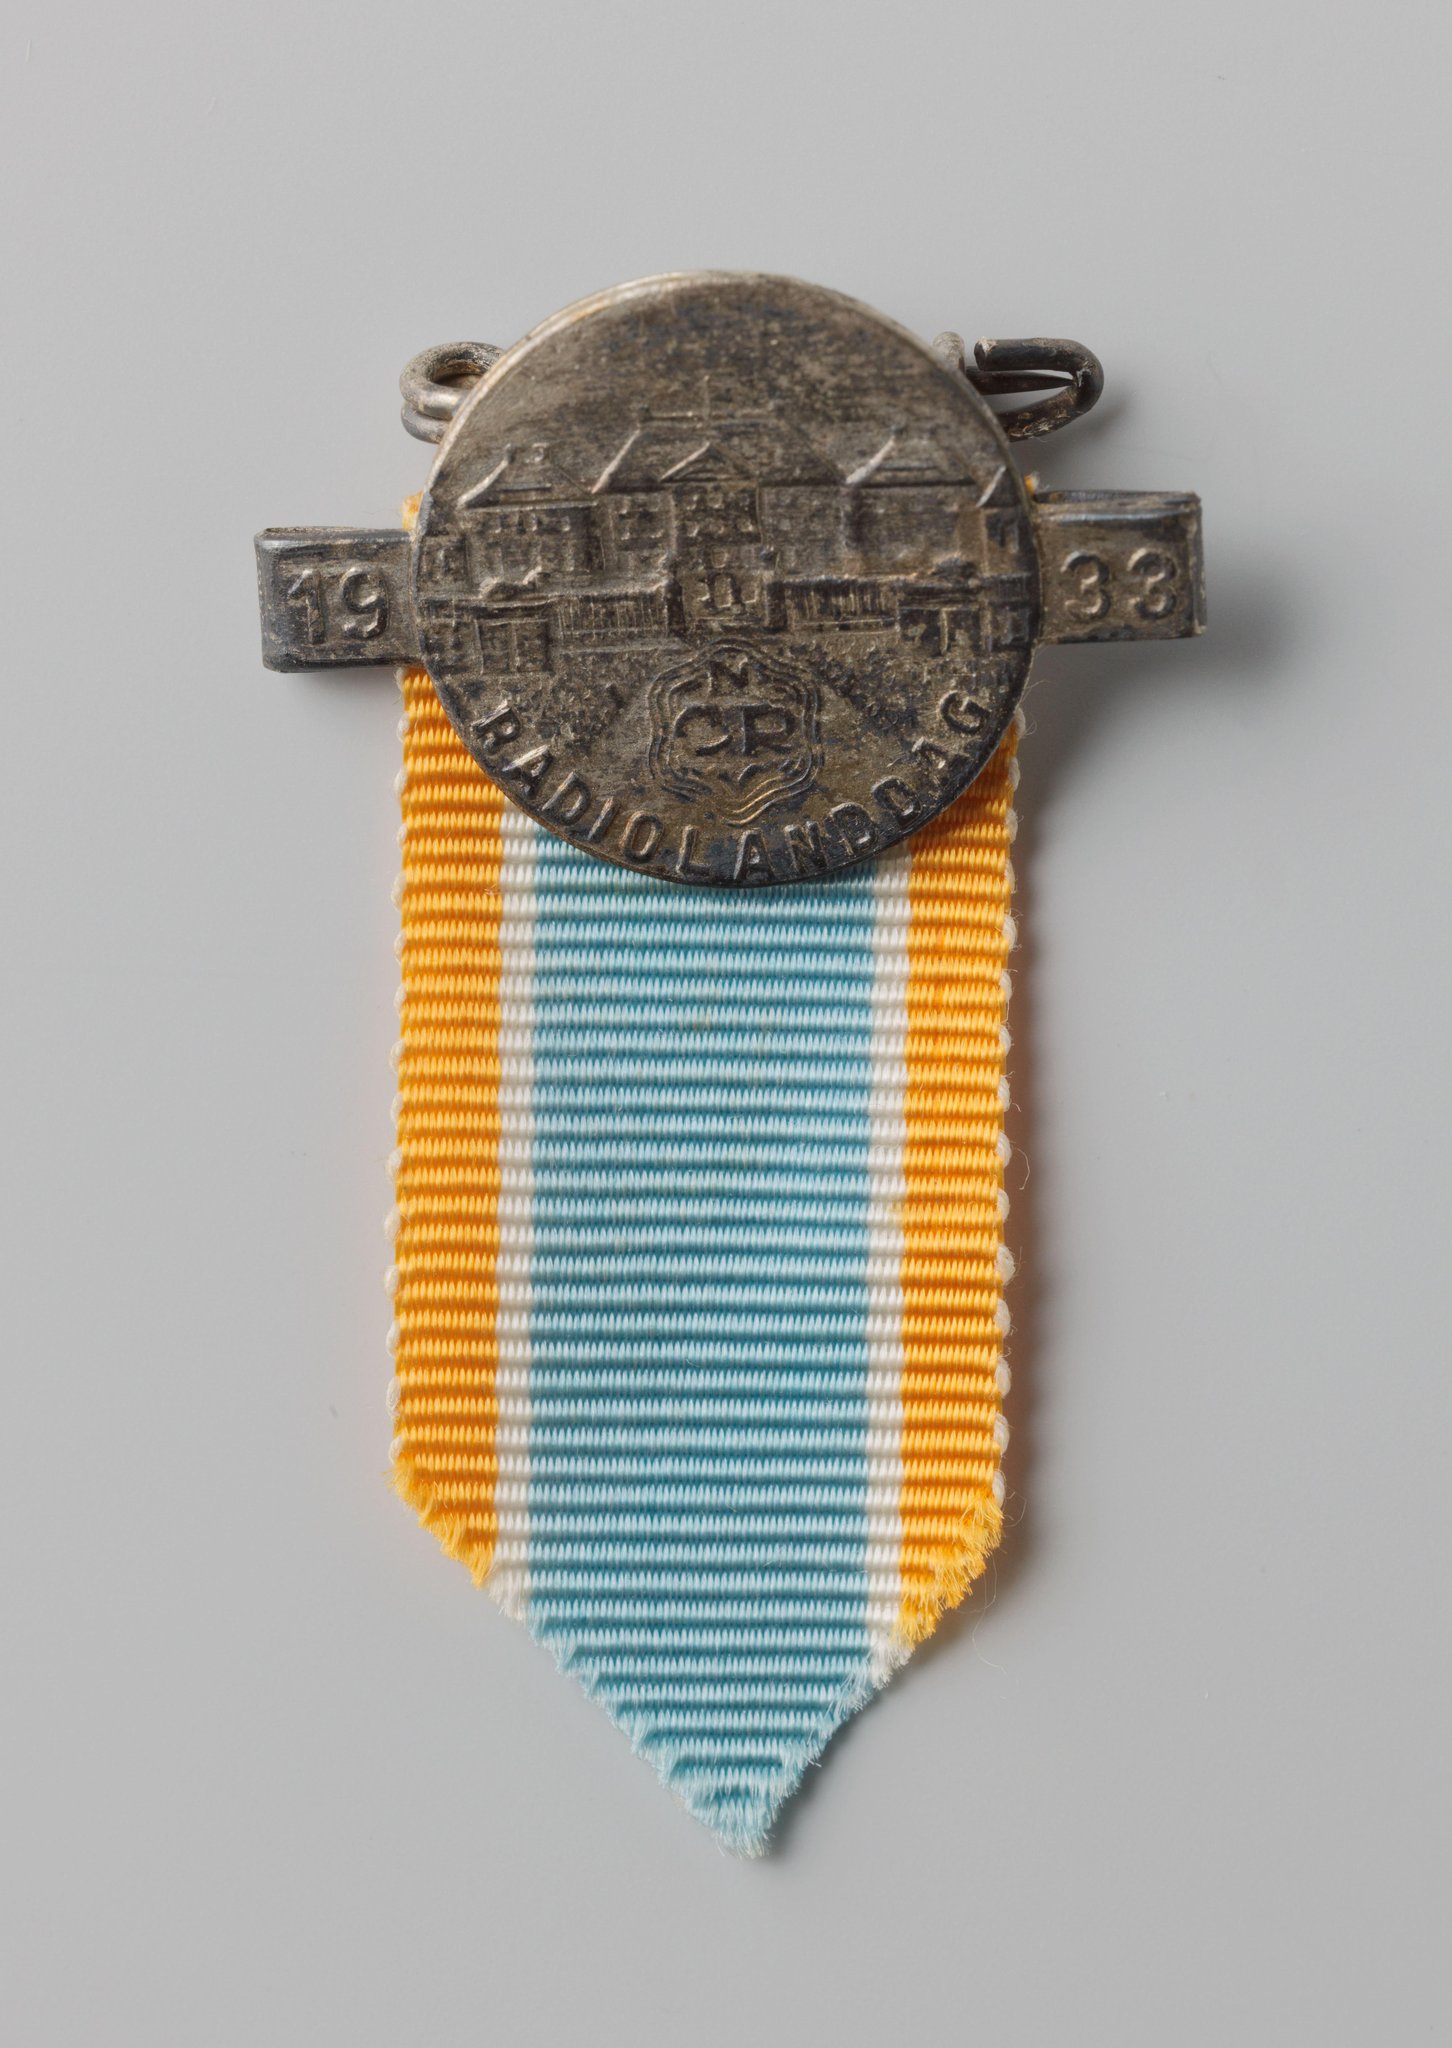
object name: pin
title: Reversspeld van de radiolanddag van de NCRV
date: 1933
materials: metal, textile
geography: netherlands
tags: netherlands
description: Rond middenstuk met de afbeelding van paleis Soestdijk; daaronder de letter N / CR / V. Langs de onderrand het opschrift RADIO LANDDAG. Aan het middendeel zitten links en rechts hoekige uiteinde met de datering: 19 / 33. De beiden uiteinde zijn omgevouwen en lopen, op de keerzijde puntig, uit. Tussen de uiteinden is een stukje gestreept textiel geklemd. De verticale strepen hebben de kleuren: oranje-wit-licht blauw-wit-oranje. Het embleem is verwant aan NG-1995-5-3, NG-1995-5-6 en 7.